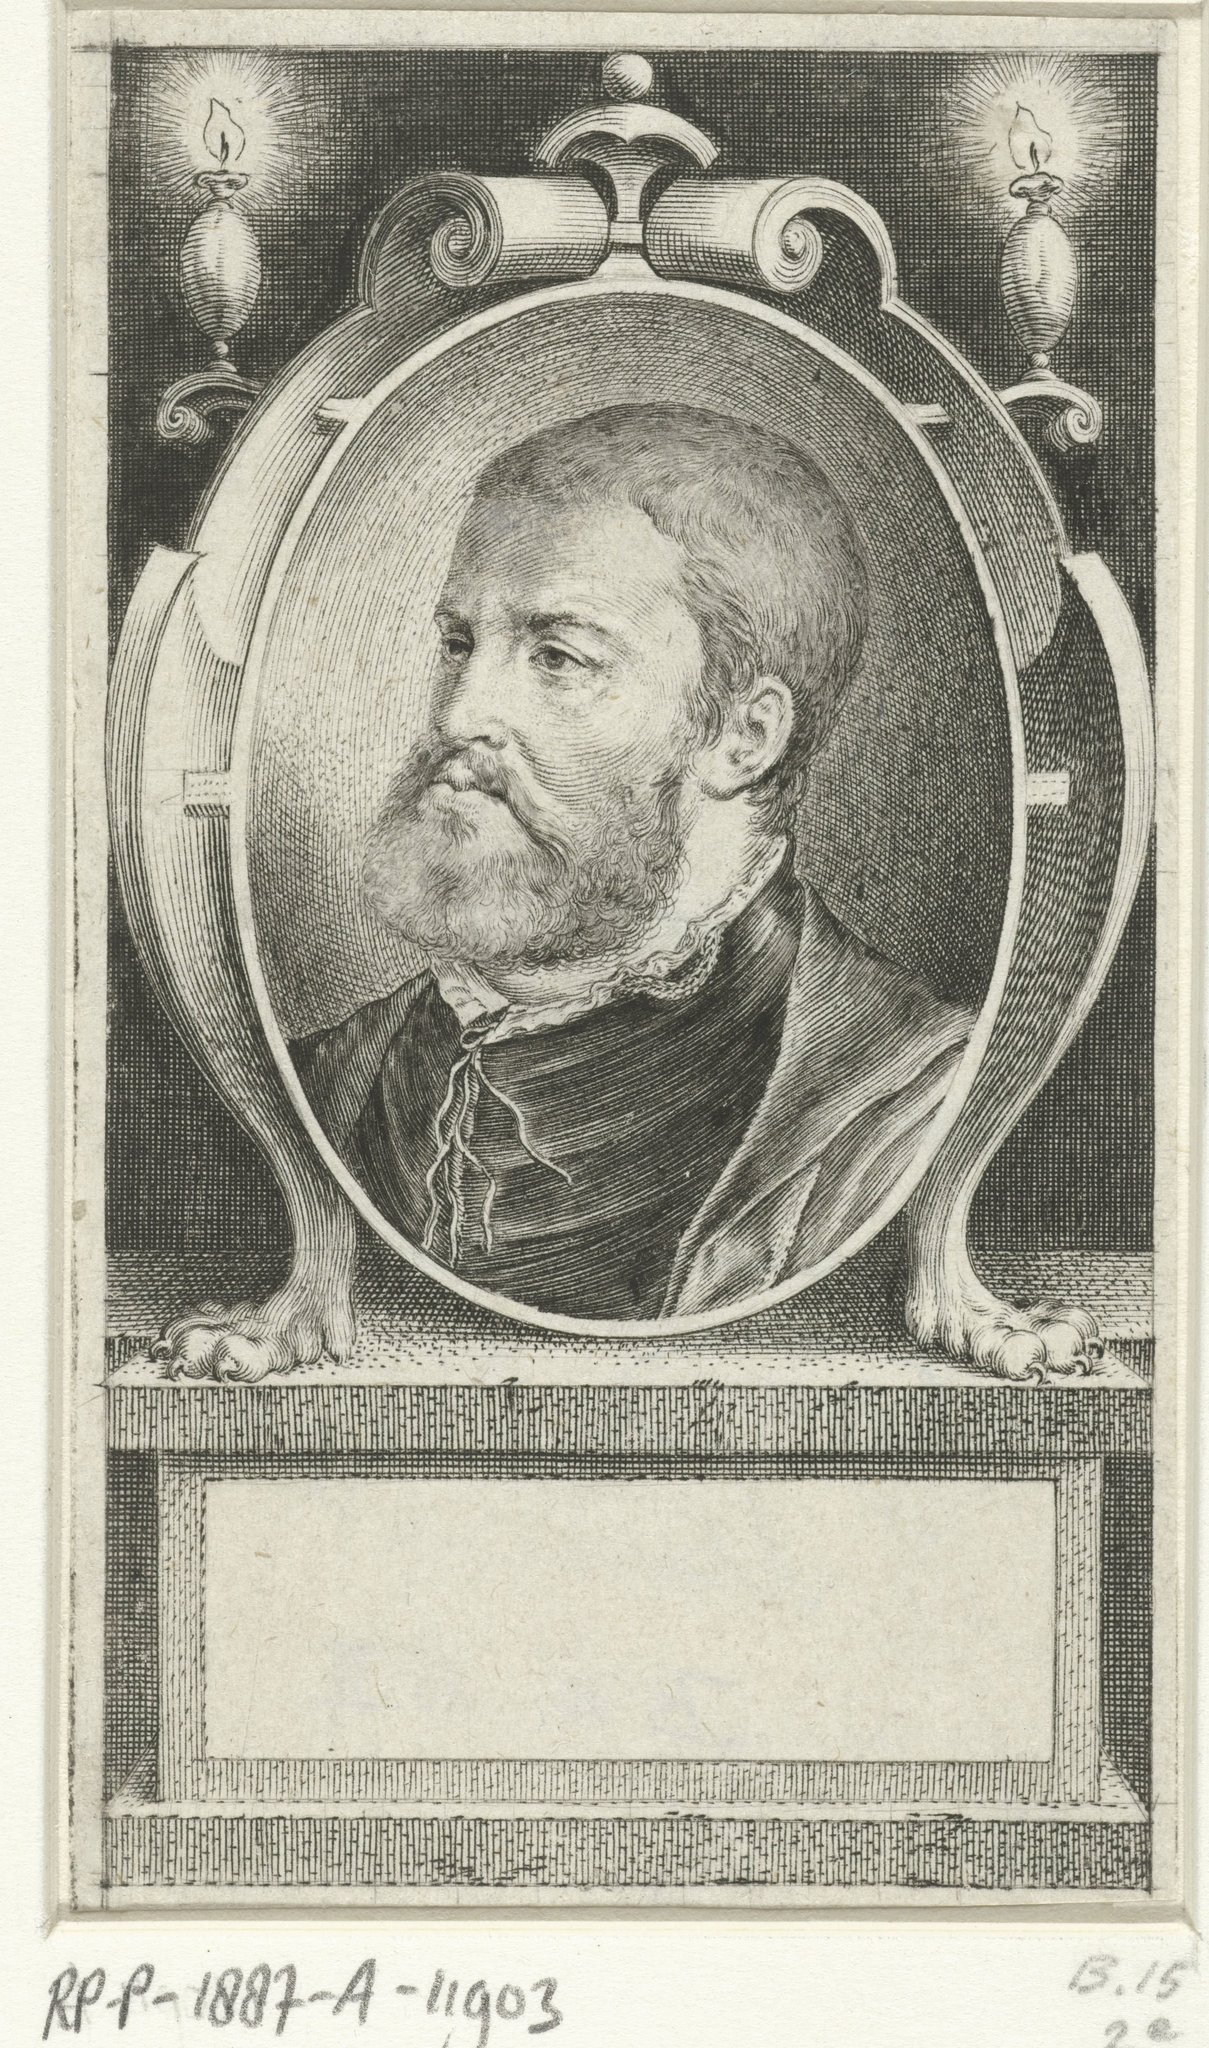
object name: print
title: Portret van Nicolaas Grudius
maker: jan harmensz. muller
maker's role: draughtsman, print maker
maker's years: 1571-1628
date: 1610-1614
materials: paper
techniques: engraving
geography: amsterdam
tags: venice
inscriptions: collector's mark: Lugt 2228, collector's mark: Lugt 1727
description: Portret van Nicolaas Grudius, raadsheer van Karel V en secretaris van het Gulden Vlies. Het portret is gevat in een ornamentele lijst op poten en aan weerszijden brandende kandelaars.